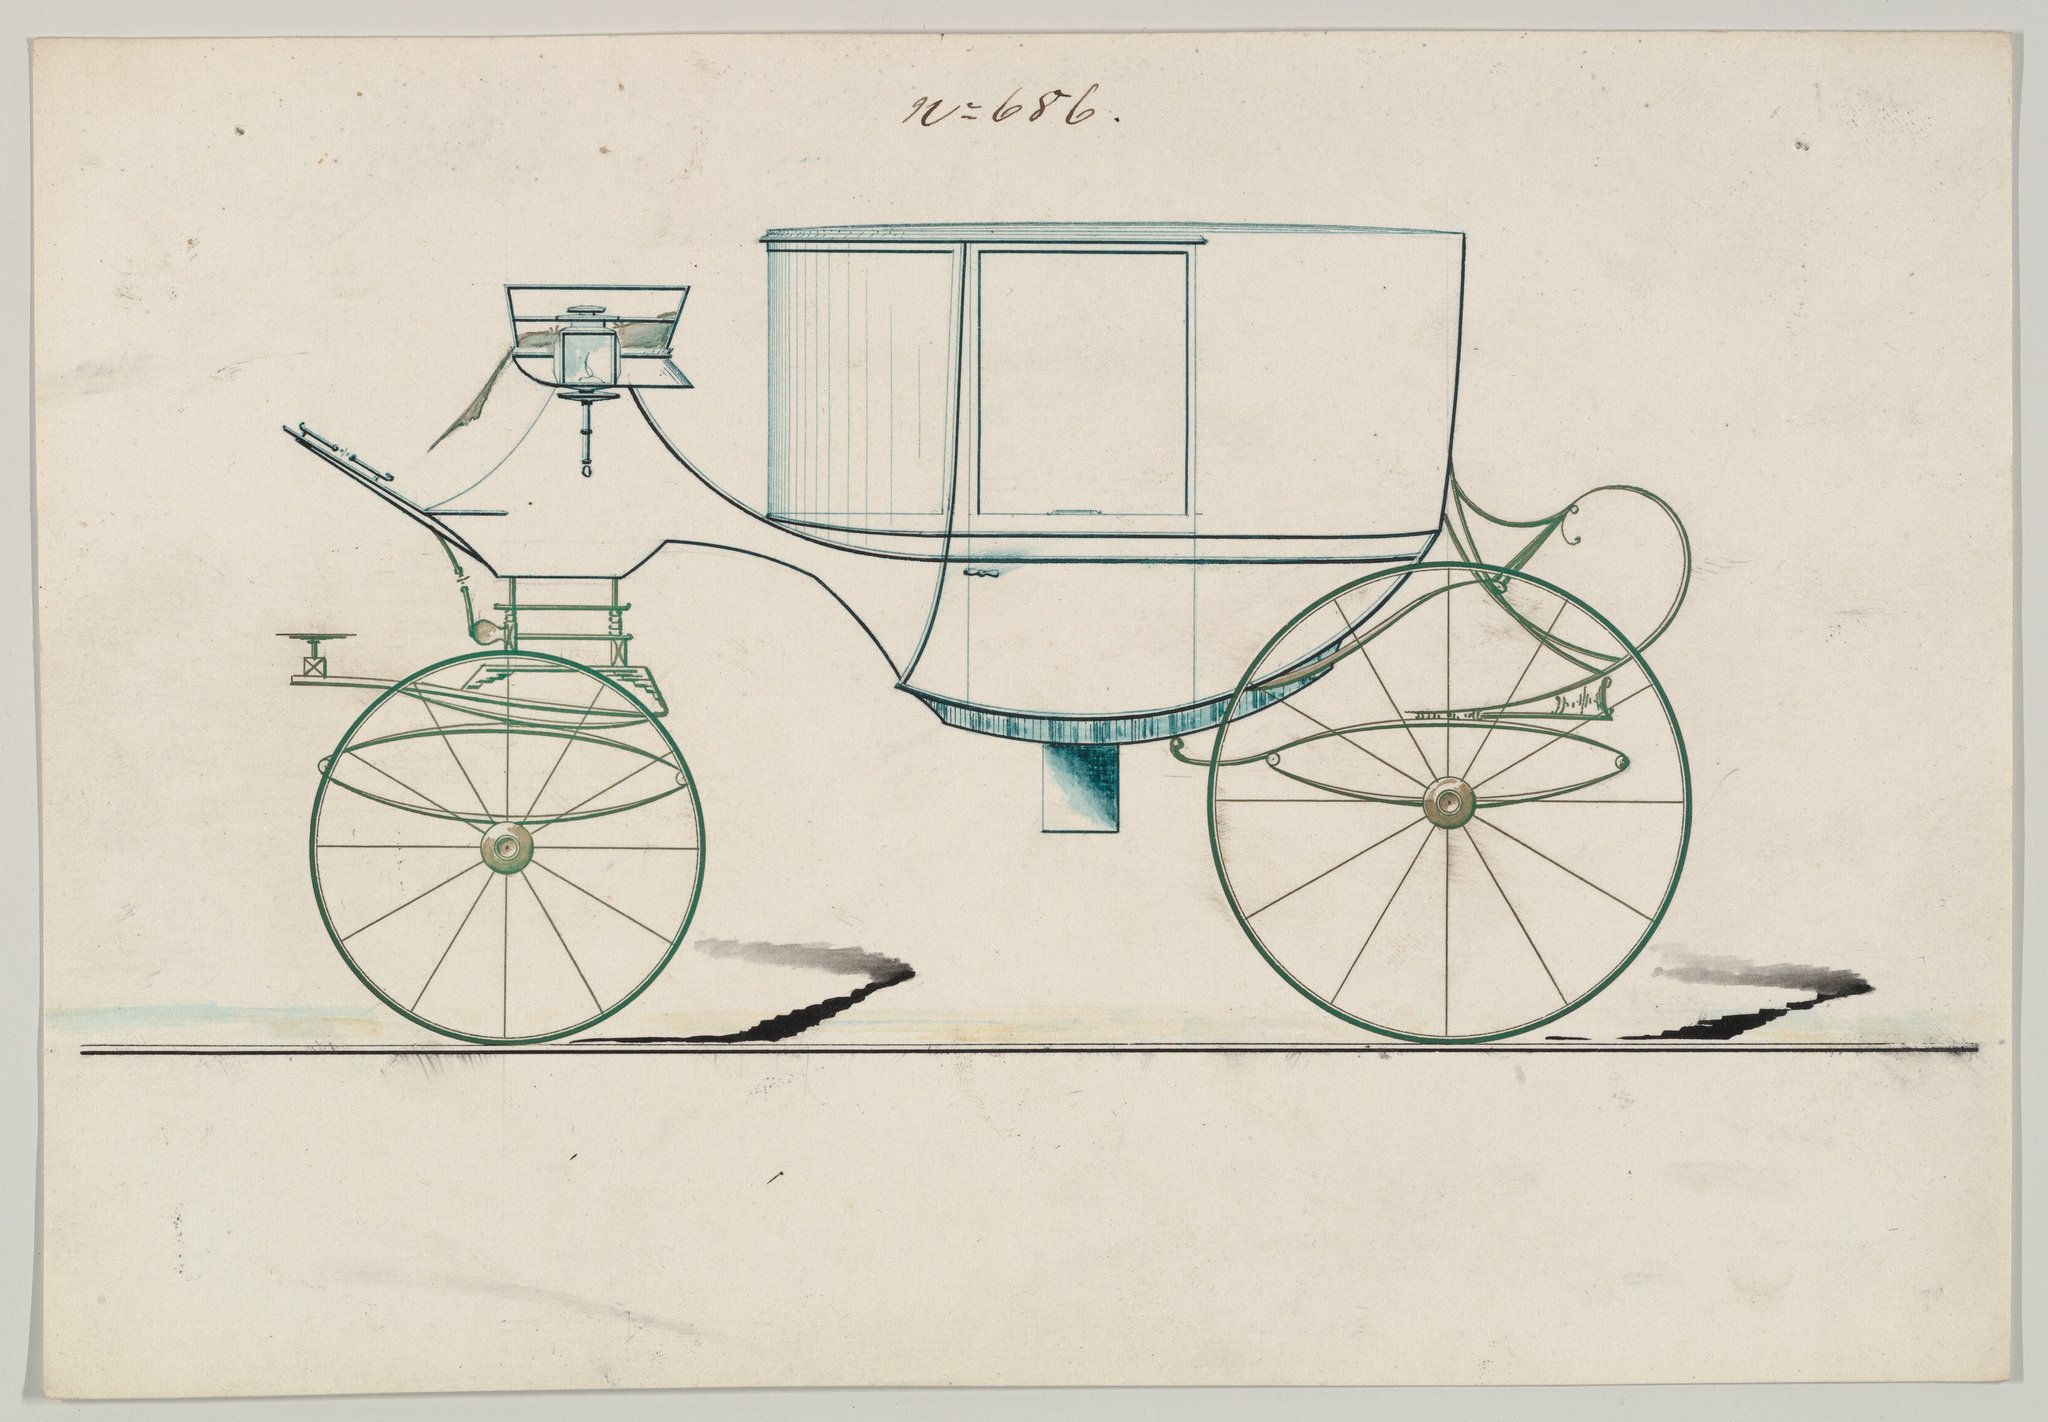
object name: drawing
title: Clarence # 686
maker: brewster & co.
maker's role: manufacturer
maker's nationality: american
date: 1850-1870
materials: gouache, watercolor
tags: carriages